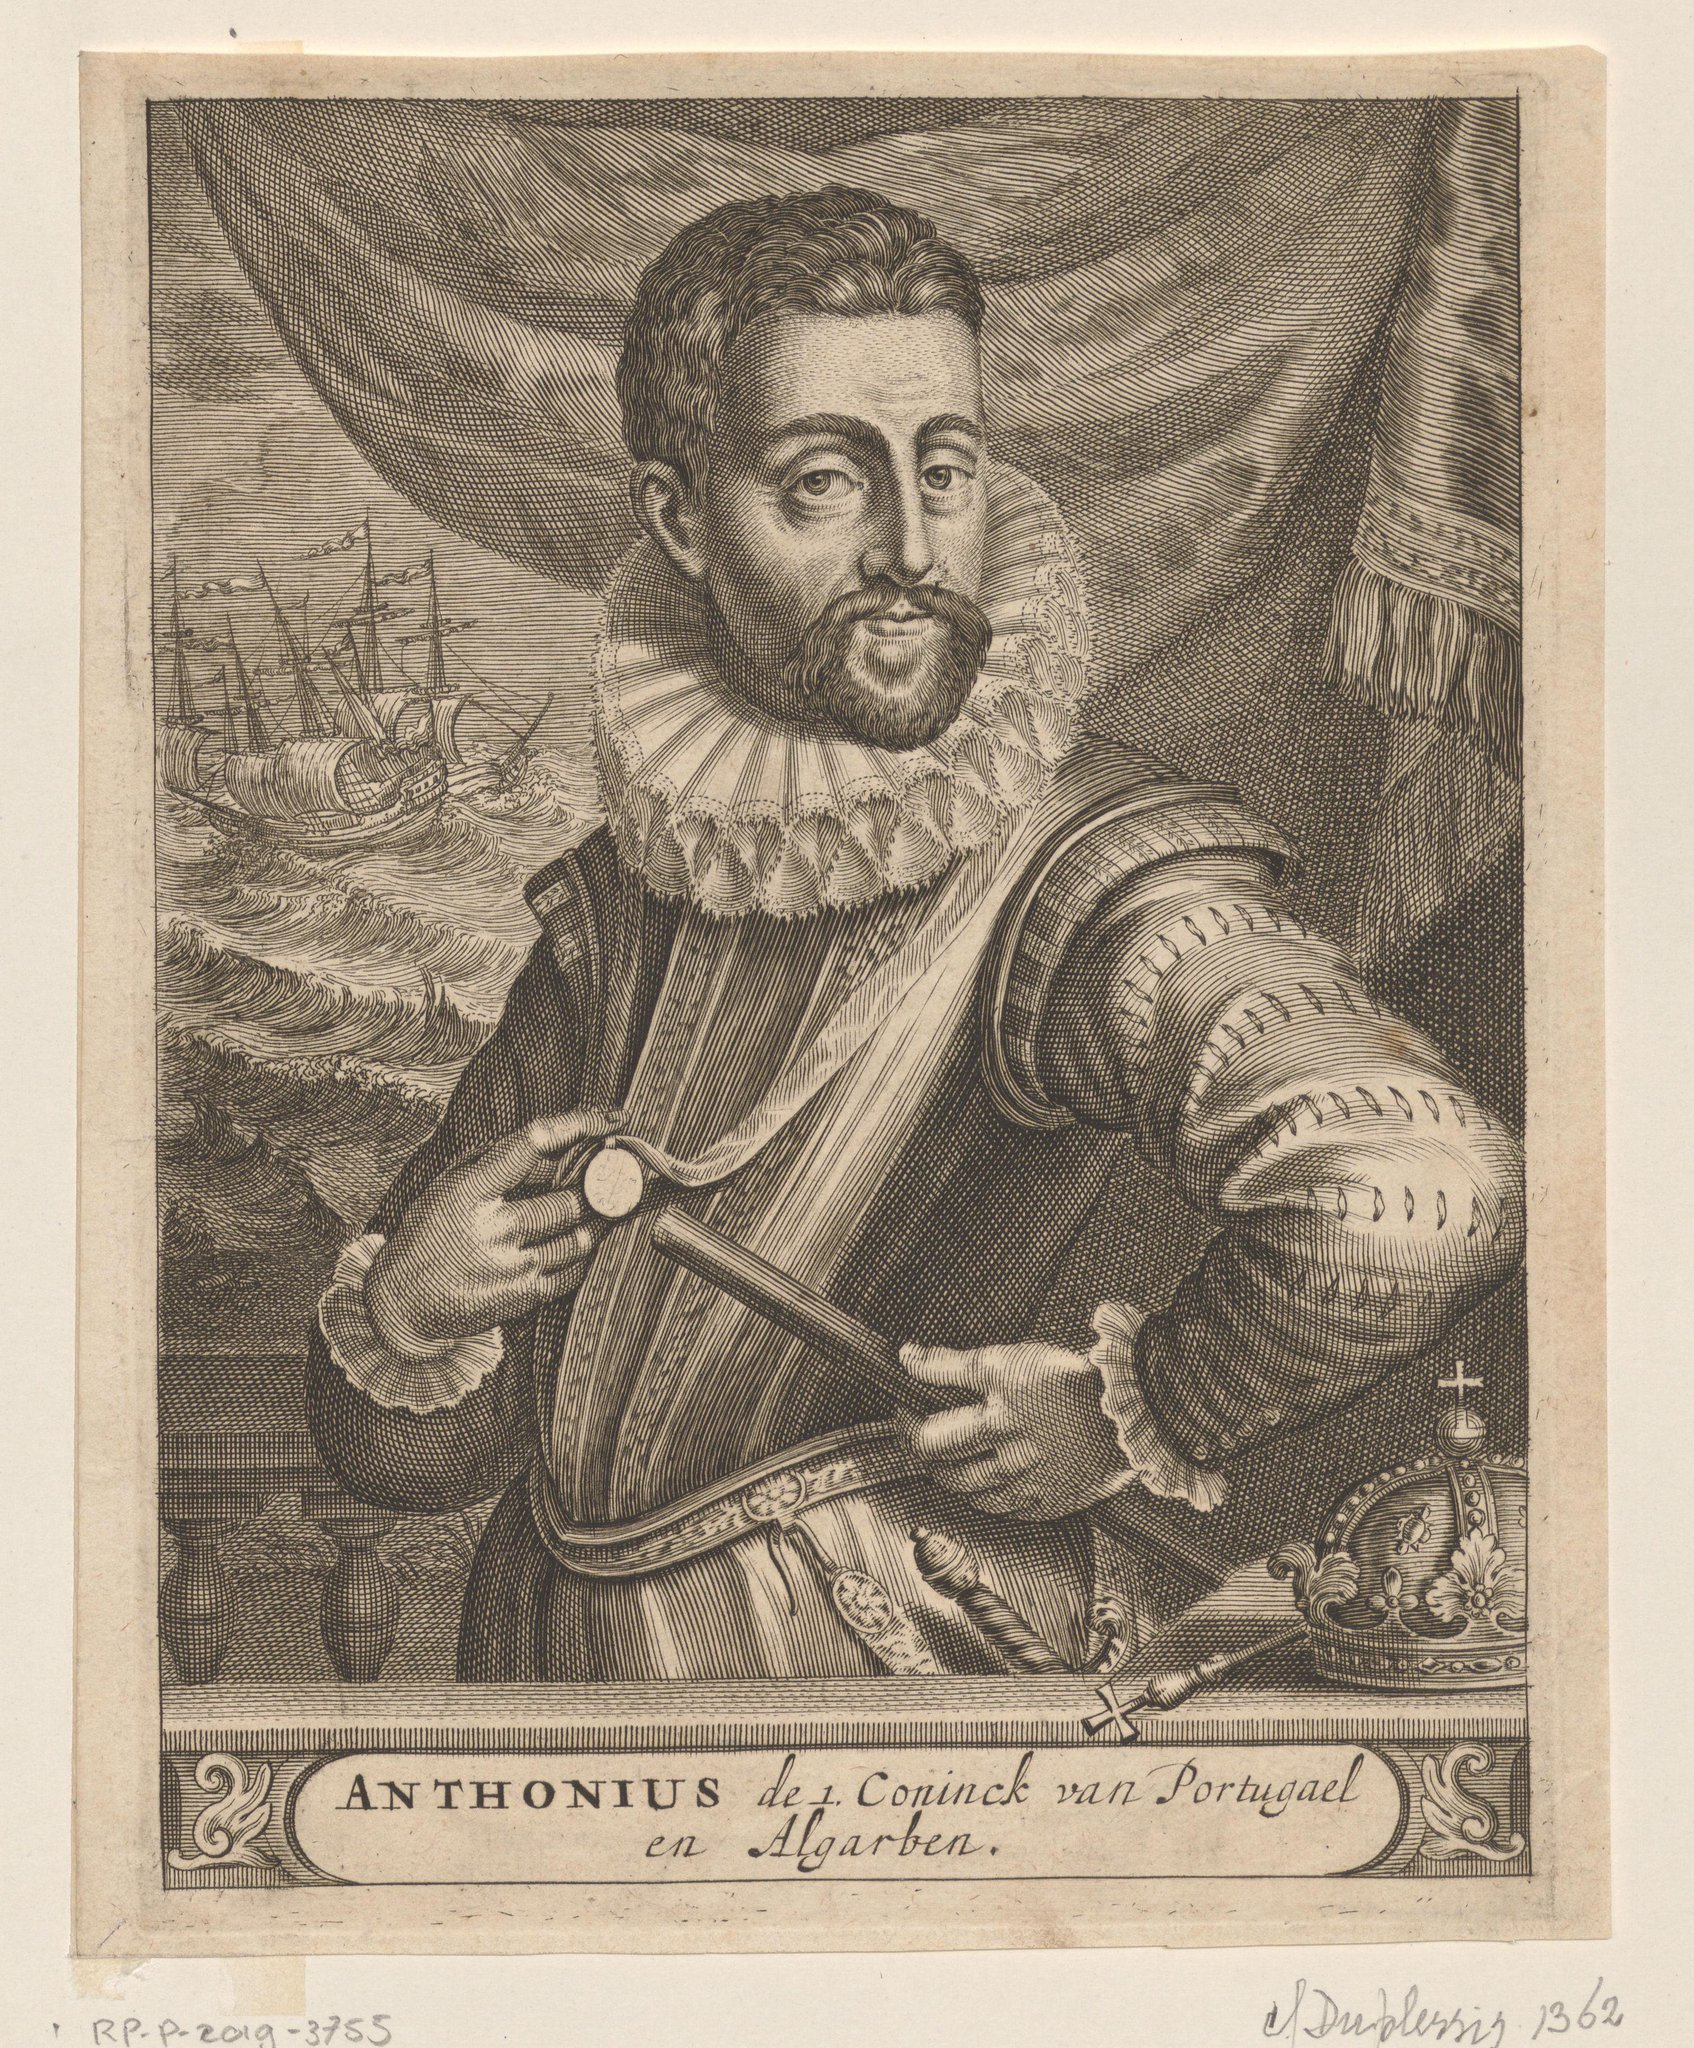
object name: print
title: Portret van Anton I, koning van Portugal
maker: Anonymous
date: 1600-1649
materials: paper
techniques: engraving, etching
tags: paris, crown (symbol of sovereignty), sailing-ship, sailing-boat, historical persons, baton of general